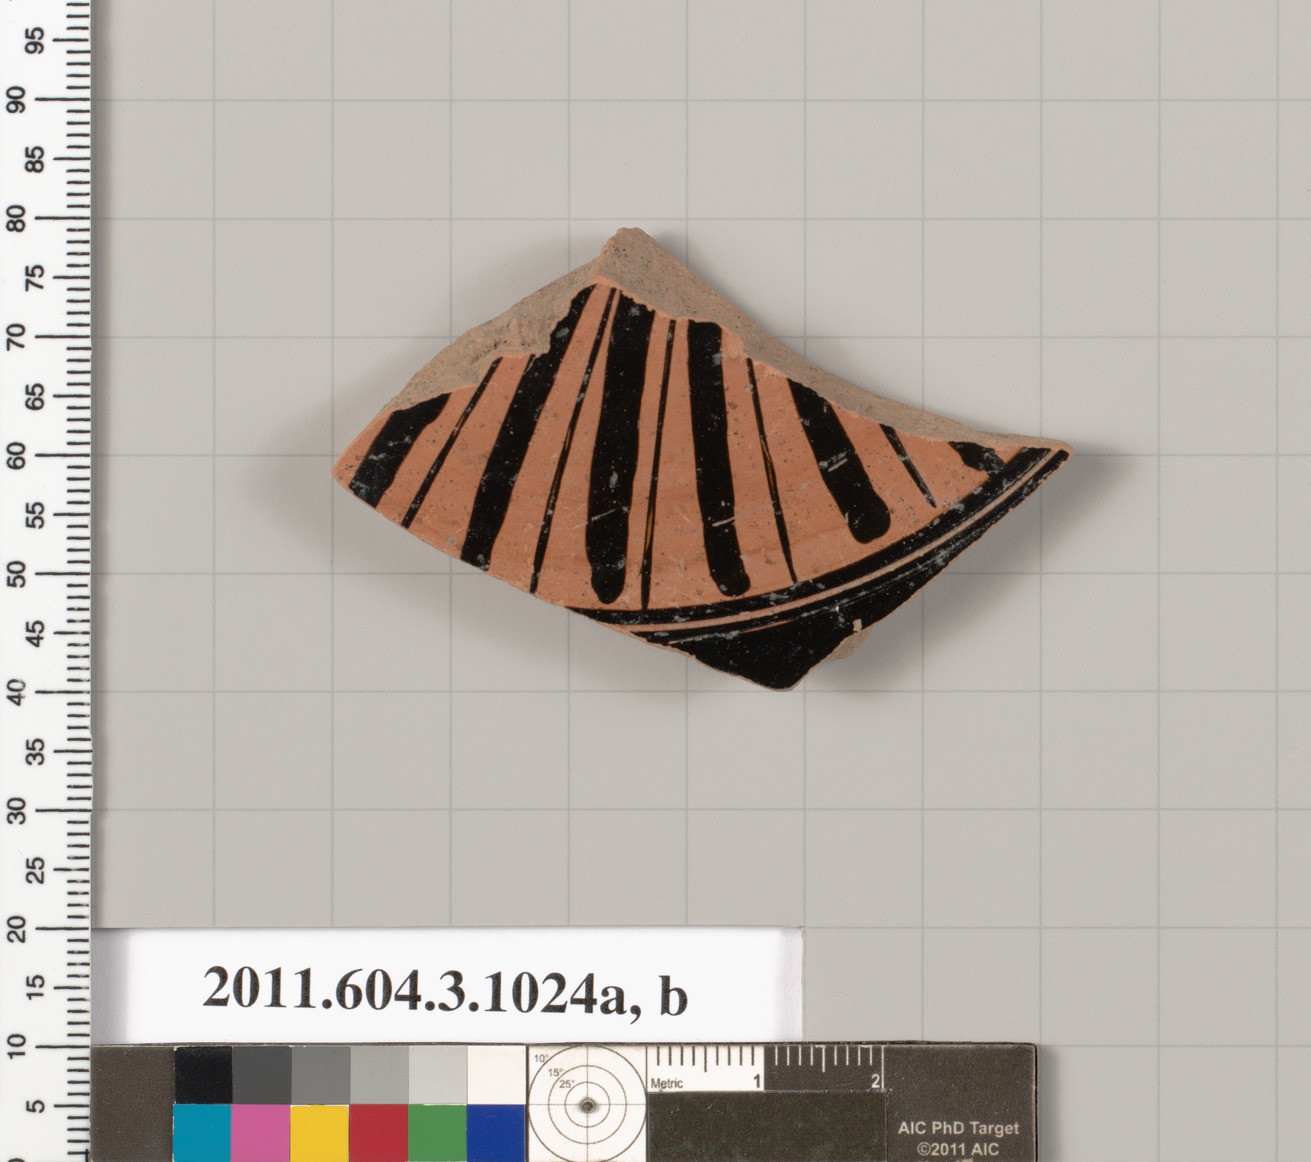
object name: lekanis lid fragment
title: Terracotta fragment of a lekanis lid (covered dish)?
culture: greek, attic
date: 475-451 BCE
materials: terracotta